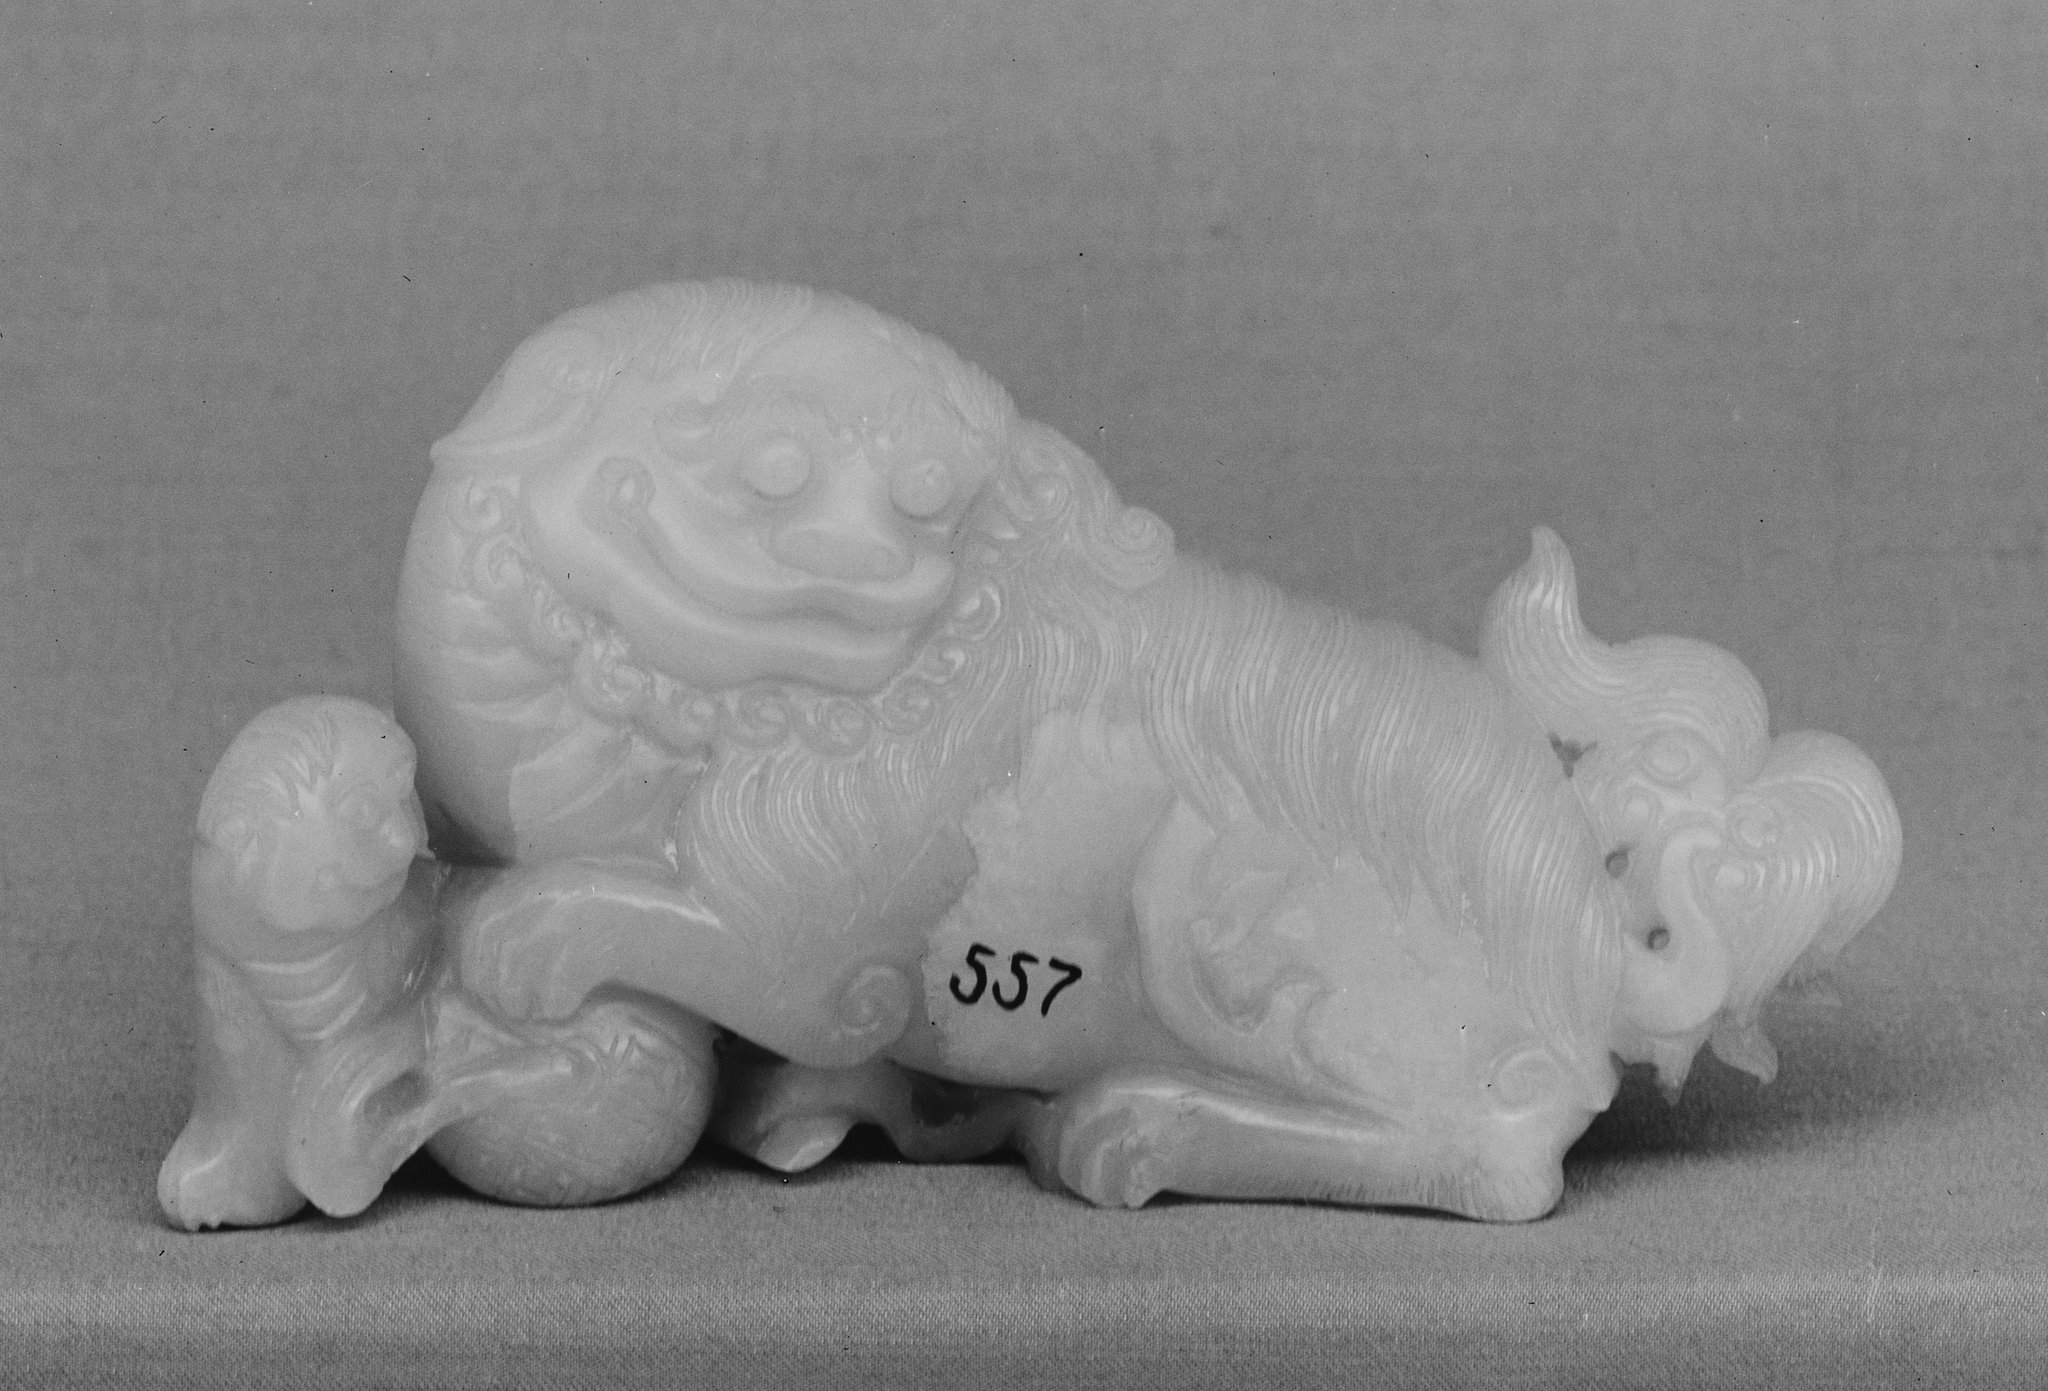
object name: figurine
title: Lion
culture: chinese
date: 1736-1795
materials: jade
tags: lions